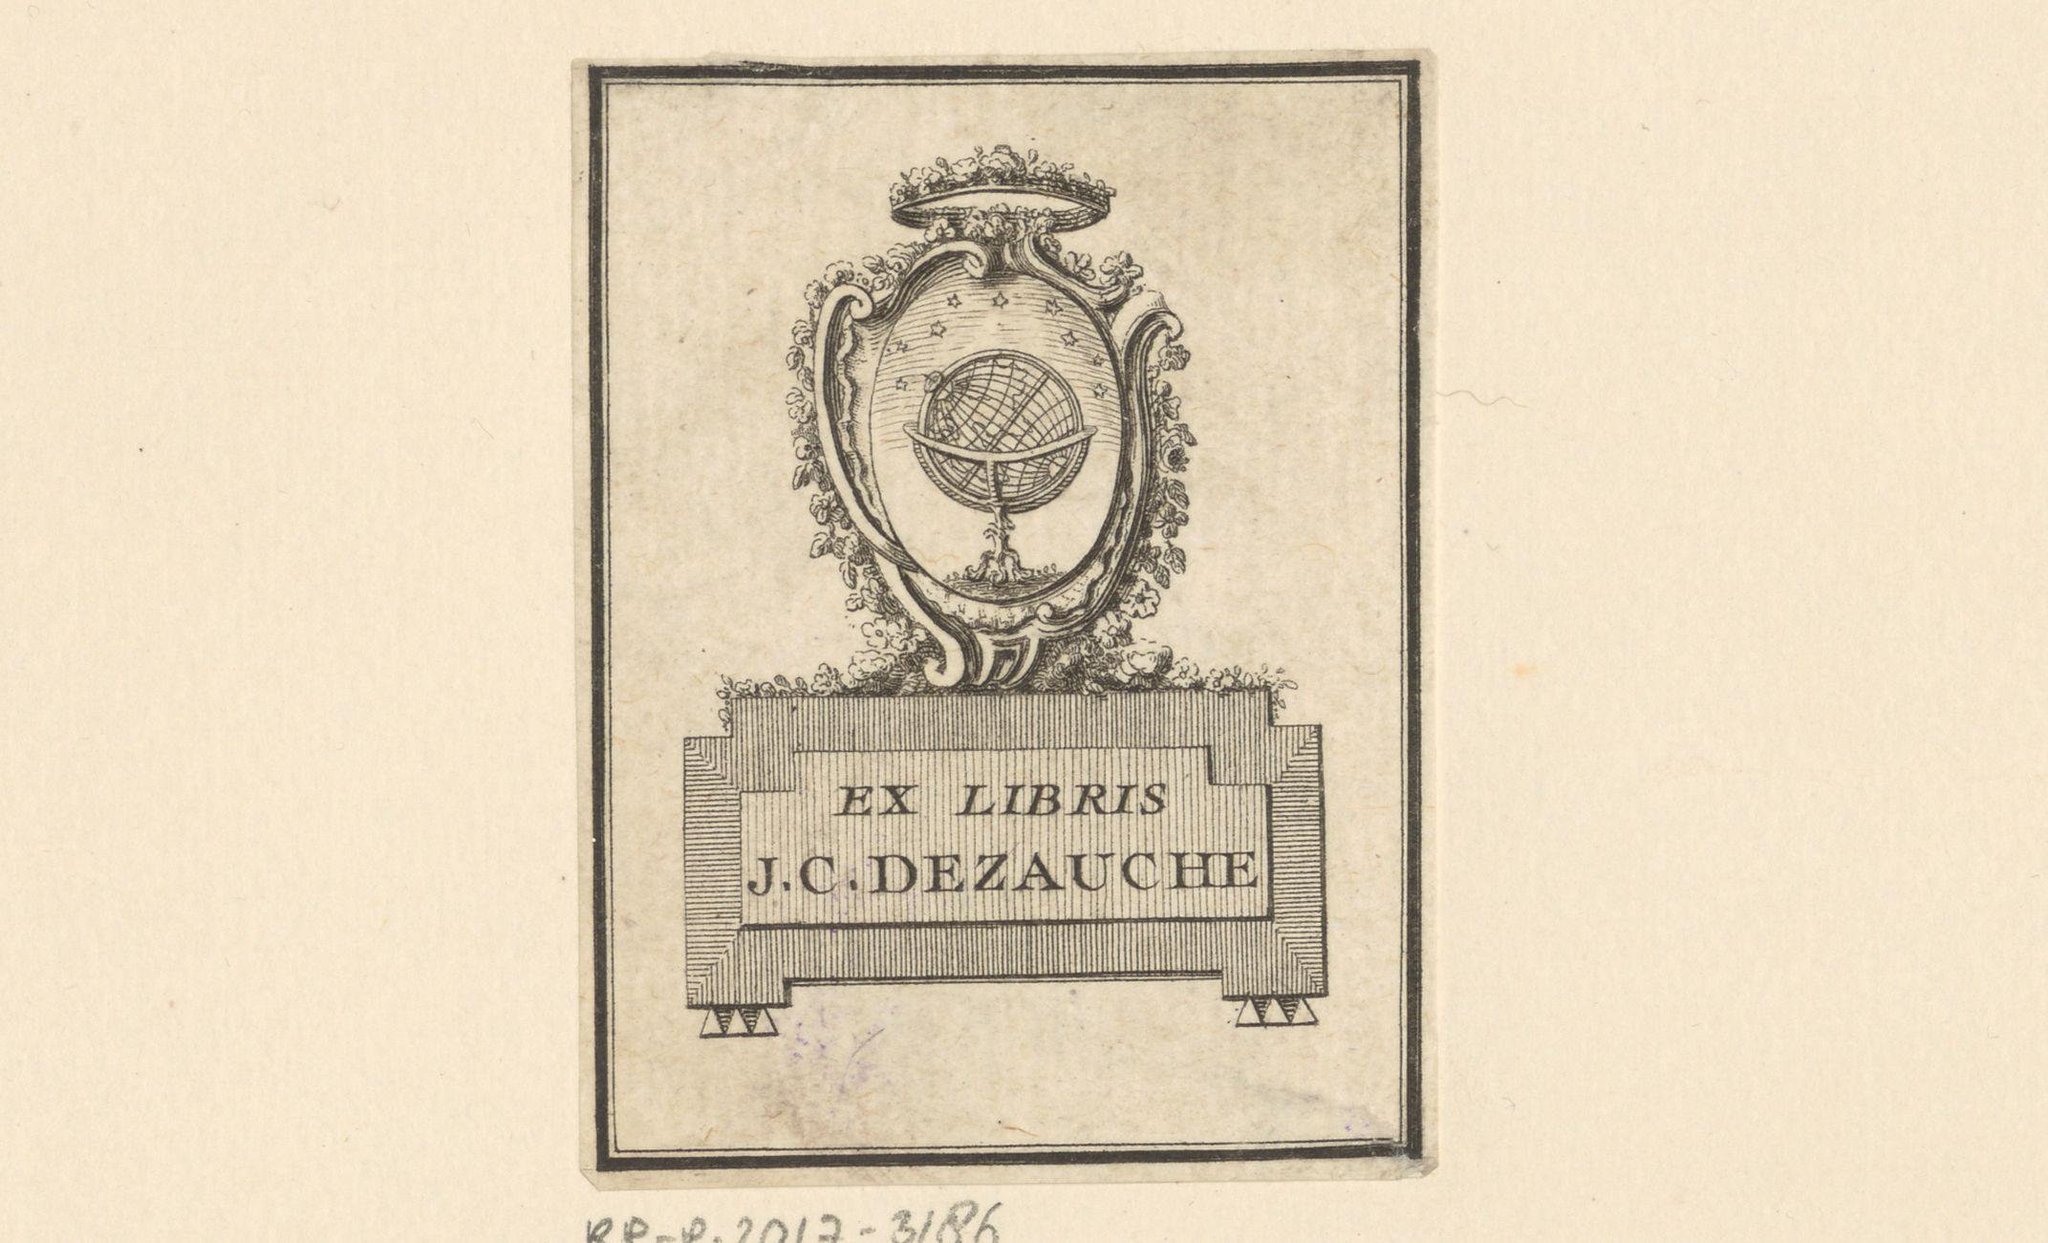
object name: bookplate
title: Ex libris van J.C. Dezauche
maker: Anonymous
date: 1750-1850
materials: paper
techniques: etching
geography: france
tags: printer, stars, globe